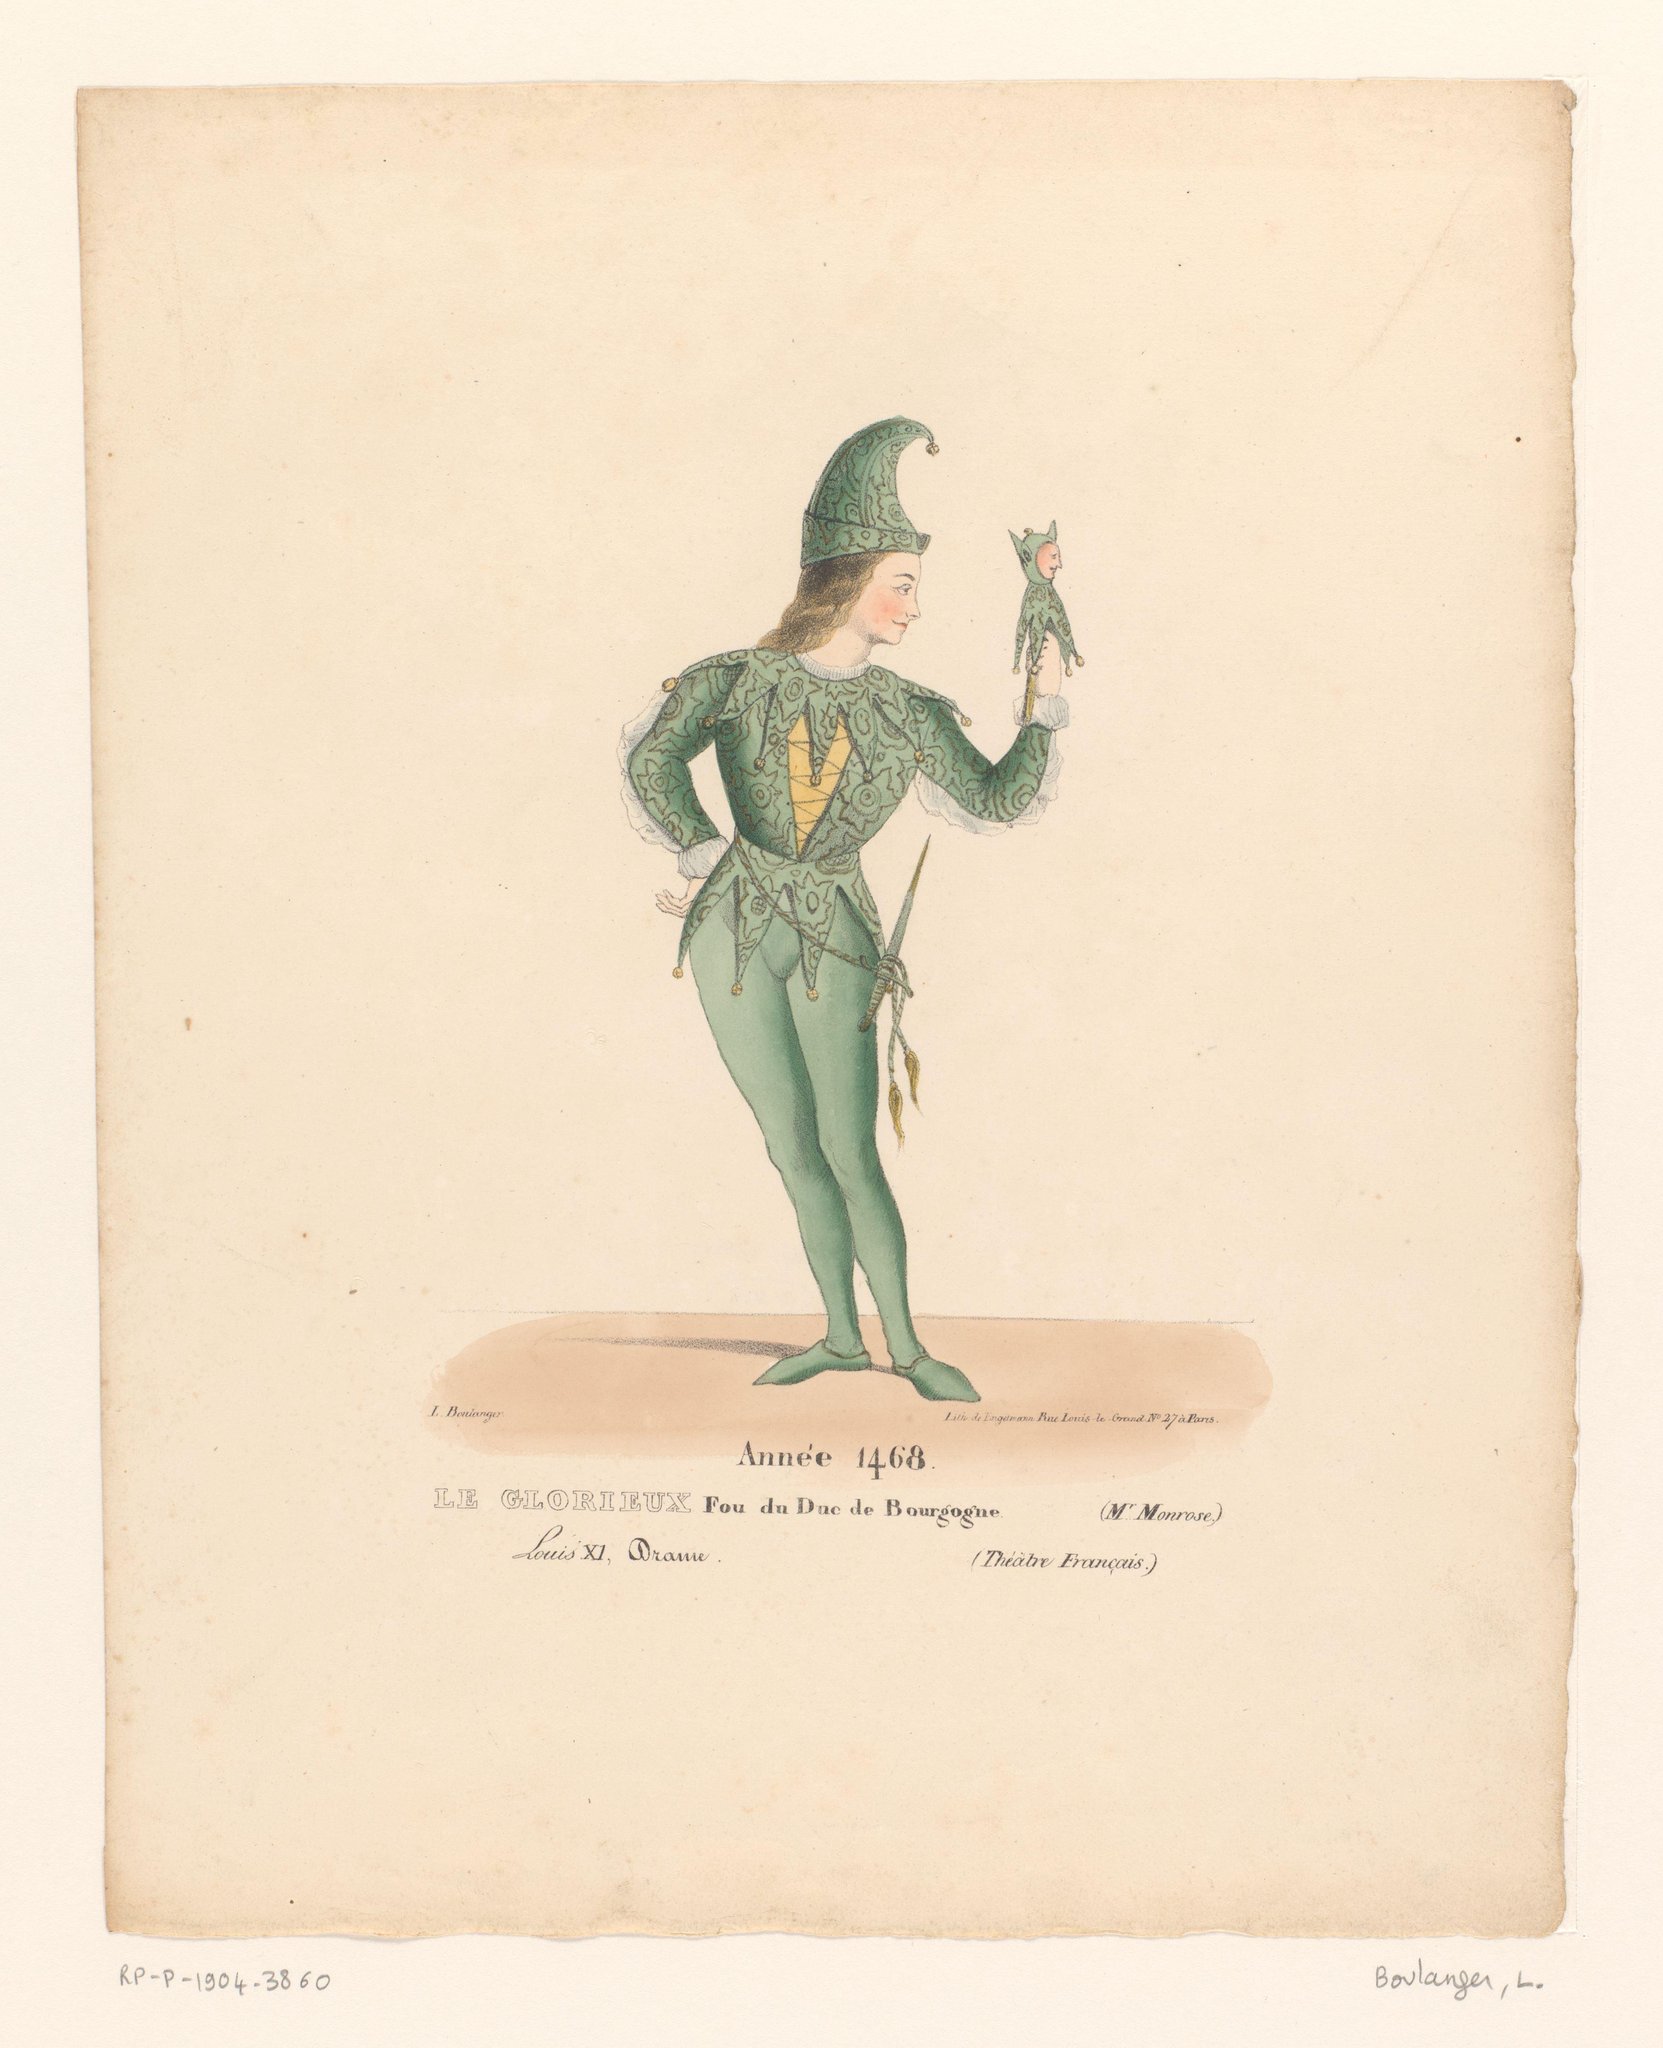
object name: print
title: Le Glorieux, fou du duc de Bourgogne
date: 1826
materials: paper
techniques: hand coloring, lithograph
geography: paris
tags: stage costume, actor (on the stage), tragedy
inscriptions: collector's mark: Lugt 2228a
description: Tiel Wetzweiler, de nar van Karel de Stoute, is een personage uit 'Quentin Durward' van Sir Walter Scott. Op dit boek is het toneelstuk 'Louis XI à Péronne' gebaseerd. Wetzweiler wordt ook wel 'Le Glorieux' (de Roemrijke) genoemd.